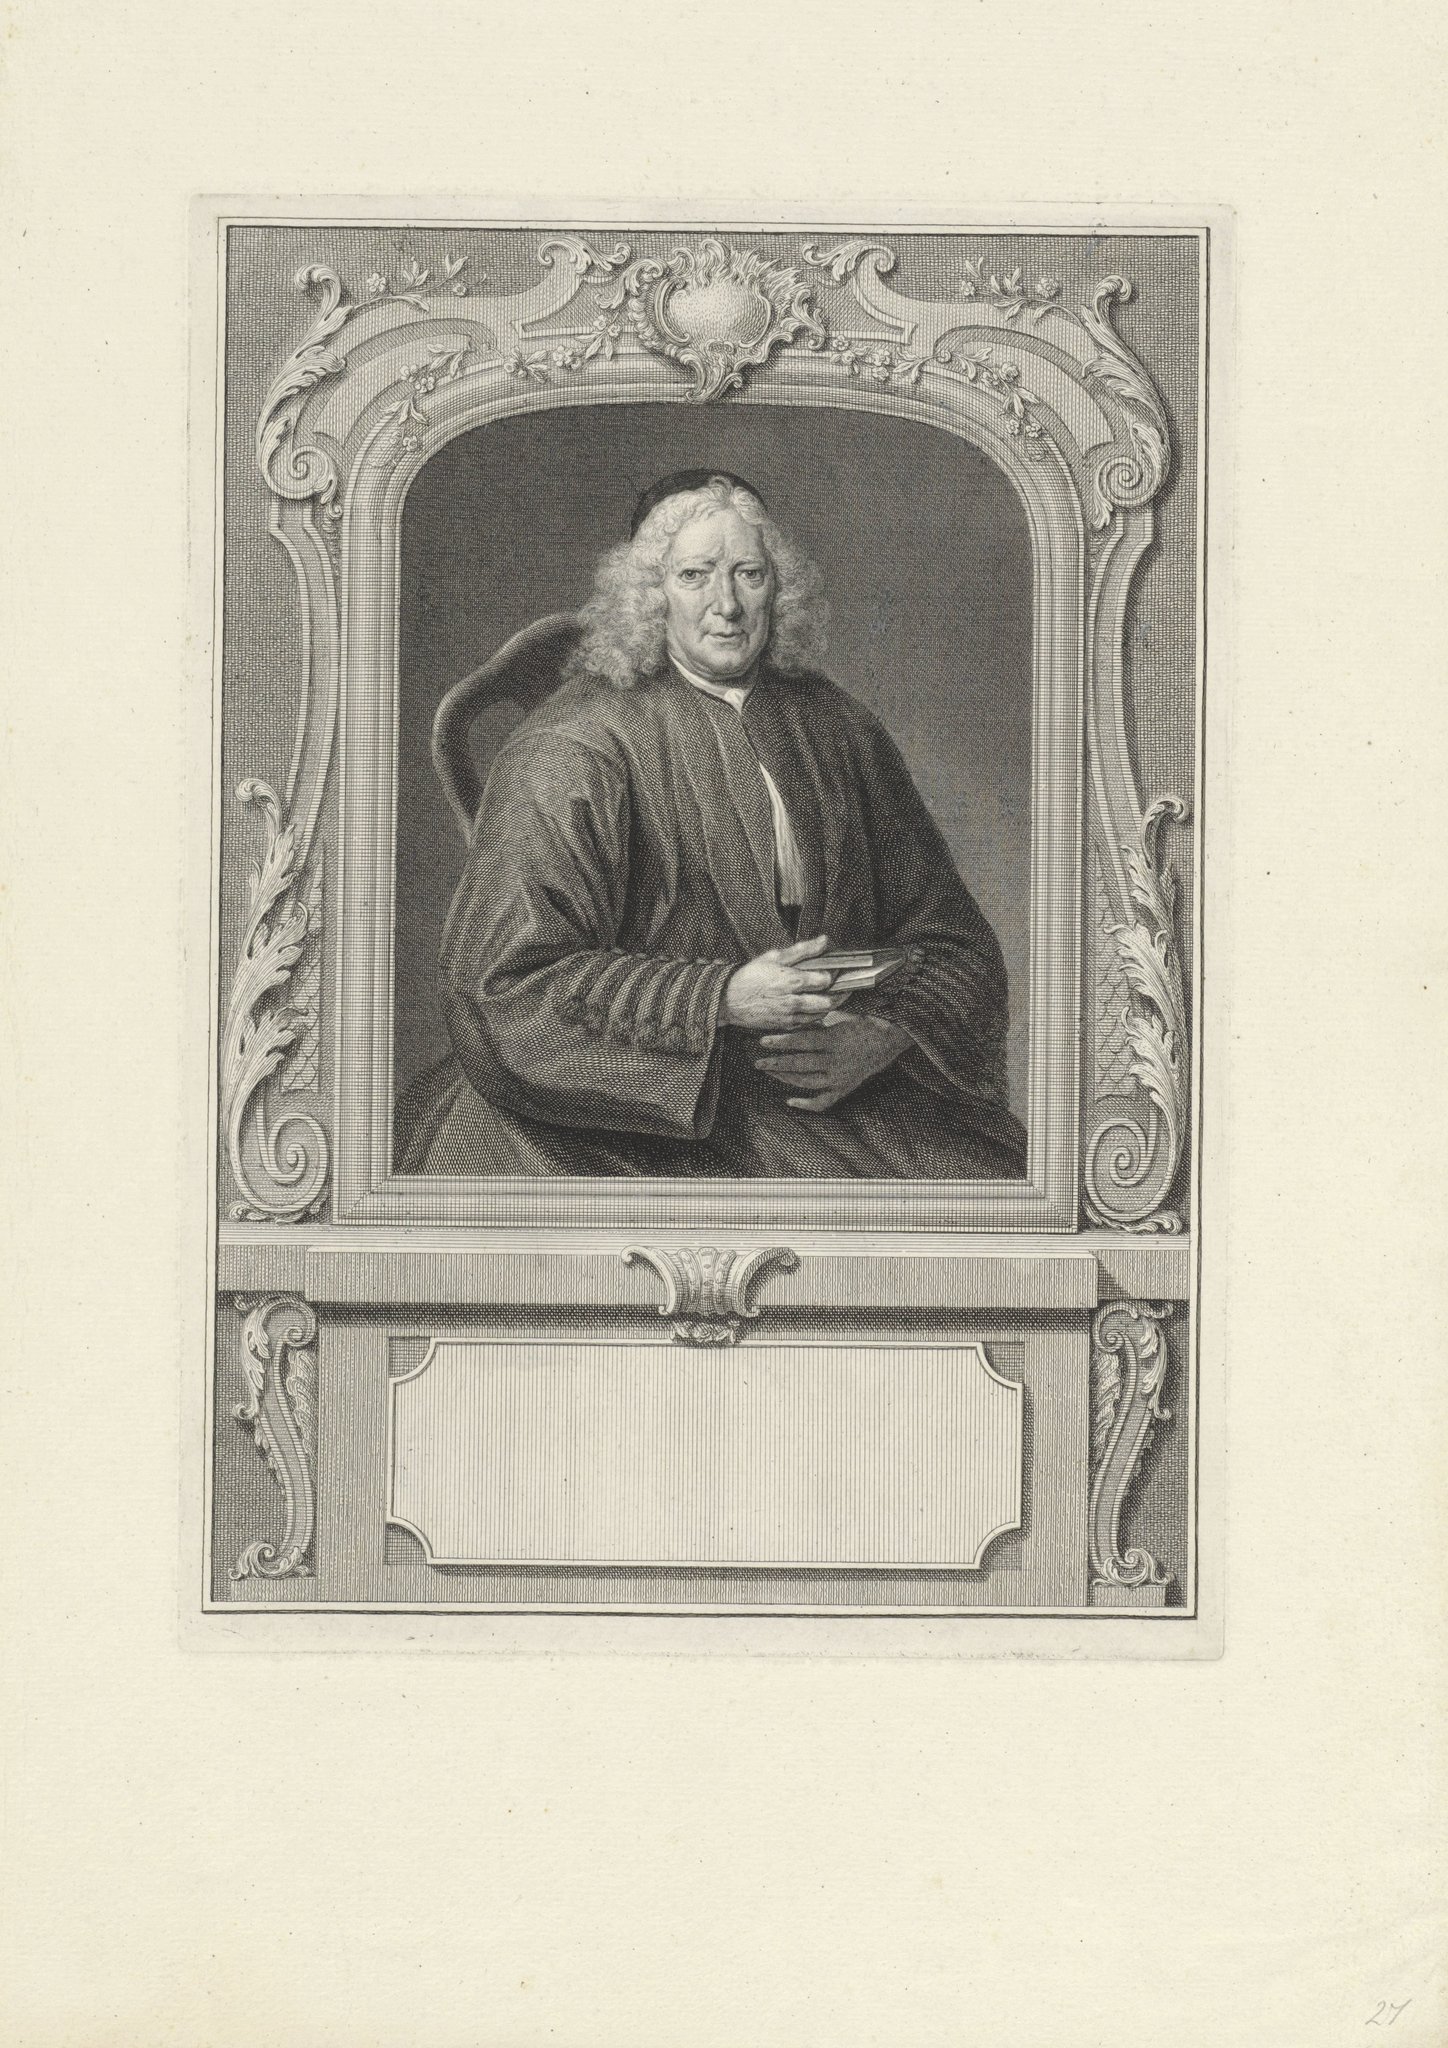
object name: print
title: Portret van Josephus de Longas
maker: pieter tanjé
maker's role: draughtsman, print maker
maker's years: 1706-1761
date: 1716-1761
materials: paper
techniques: engraving, etching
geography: amsterdam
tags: the bible as a book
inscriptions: collector's mark: Lugt 240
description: Portret van Josephus de Longas, vice-president van de Hollandse Zending, met een bijbel in zijn hand.